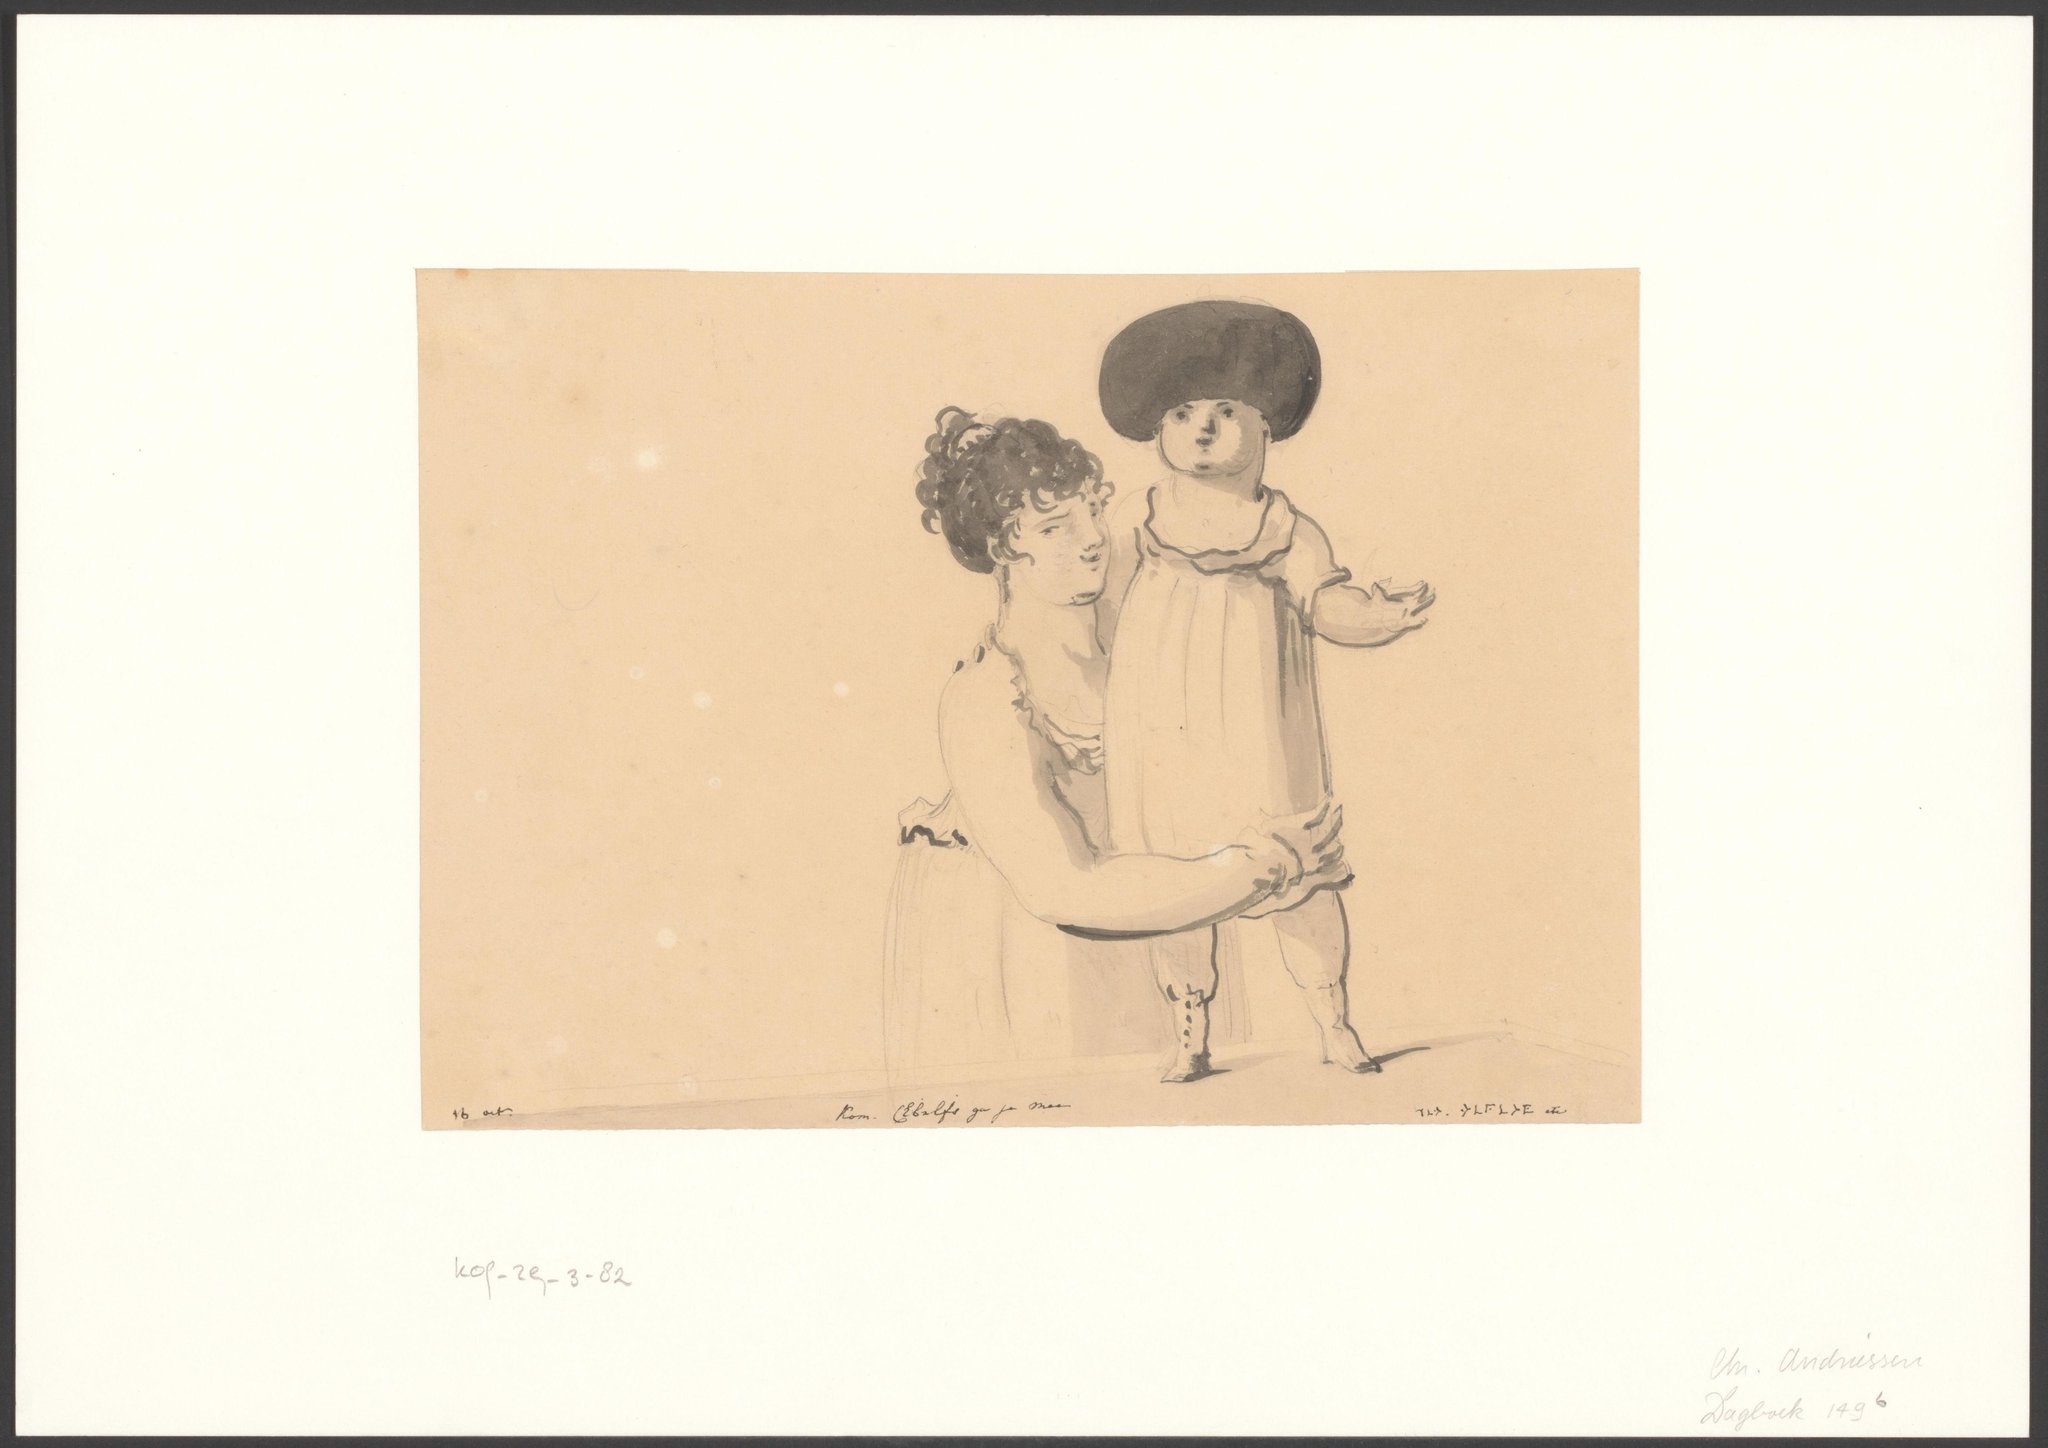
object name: drawing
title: Vrouw met een kind met valhelm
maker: christiaan andriessen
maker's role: draughtsman, print maker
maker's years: 1775-1846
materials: ink, paper, pencil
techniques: brush, pen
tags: mother and child(ren), woman and child(ren) (family group)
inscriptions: inscription: ‘Kom cebats ga je mee’, inscription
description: Dagboekblad uit het getekende dagboek dat Christiaan Andriessen bijhield van 1805 tot en met 1808.